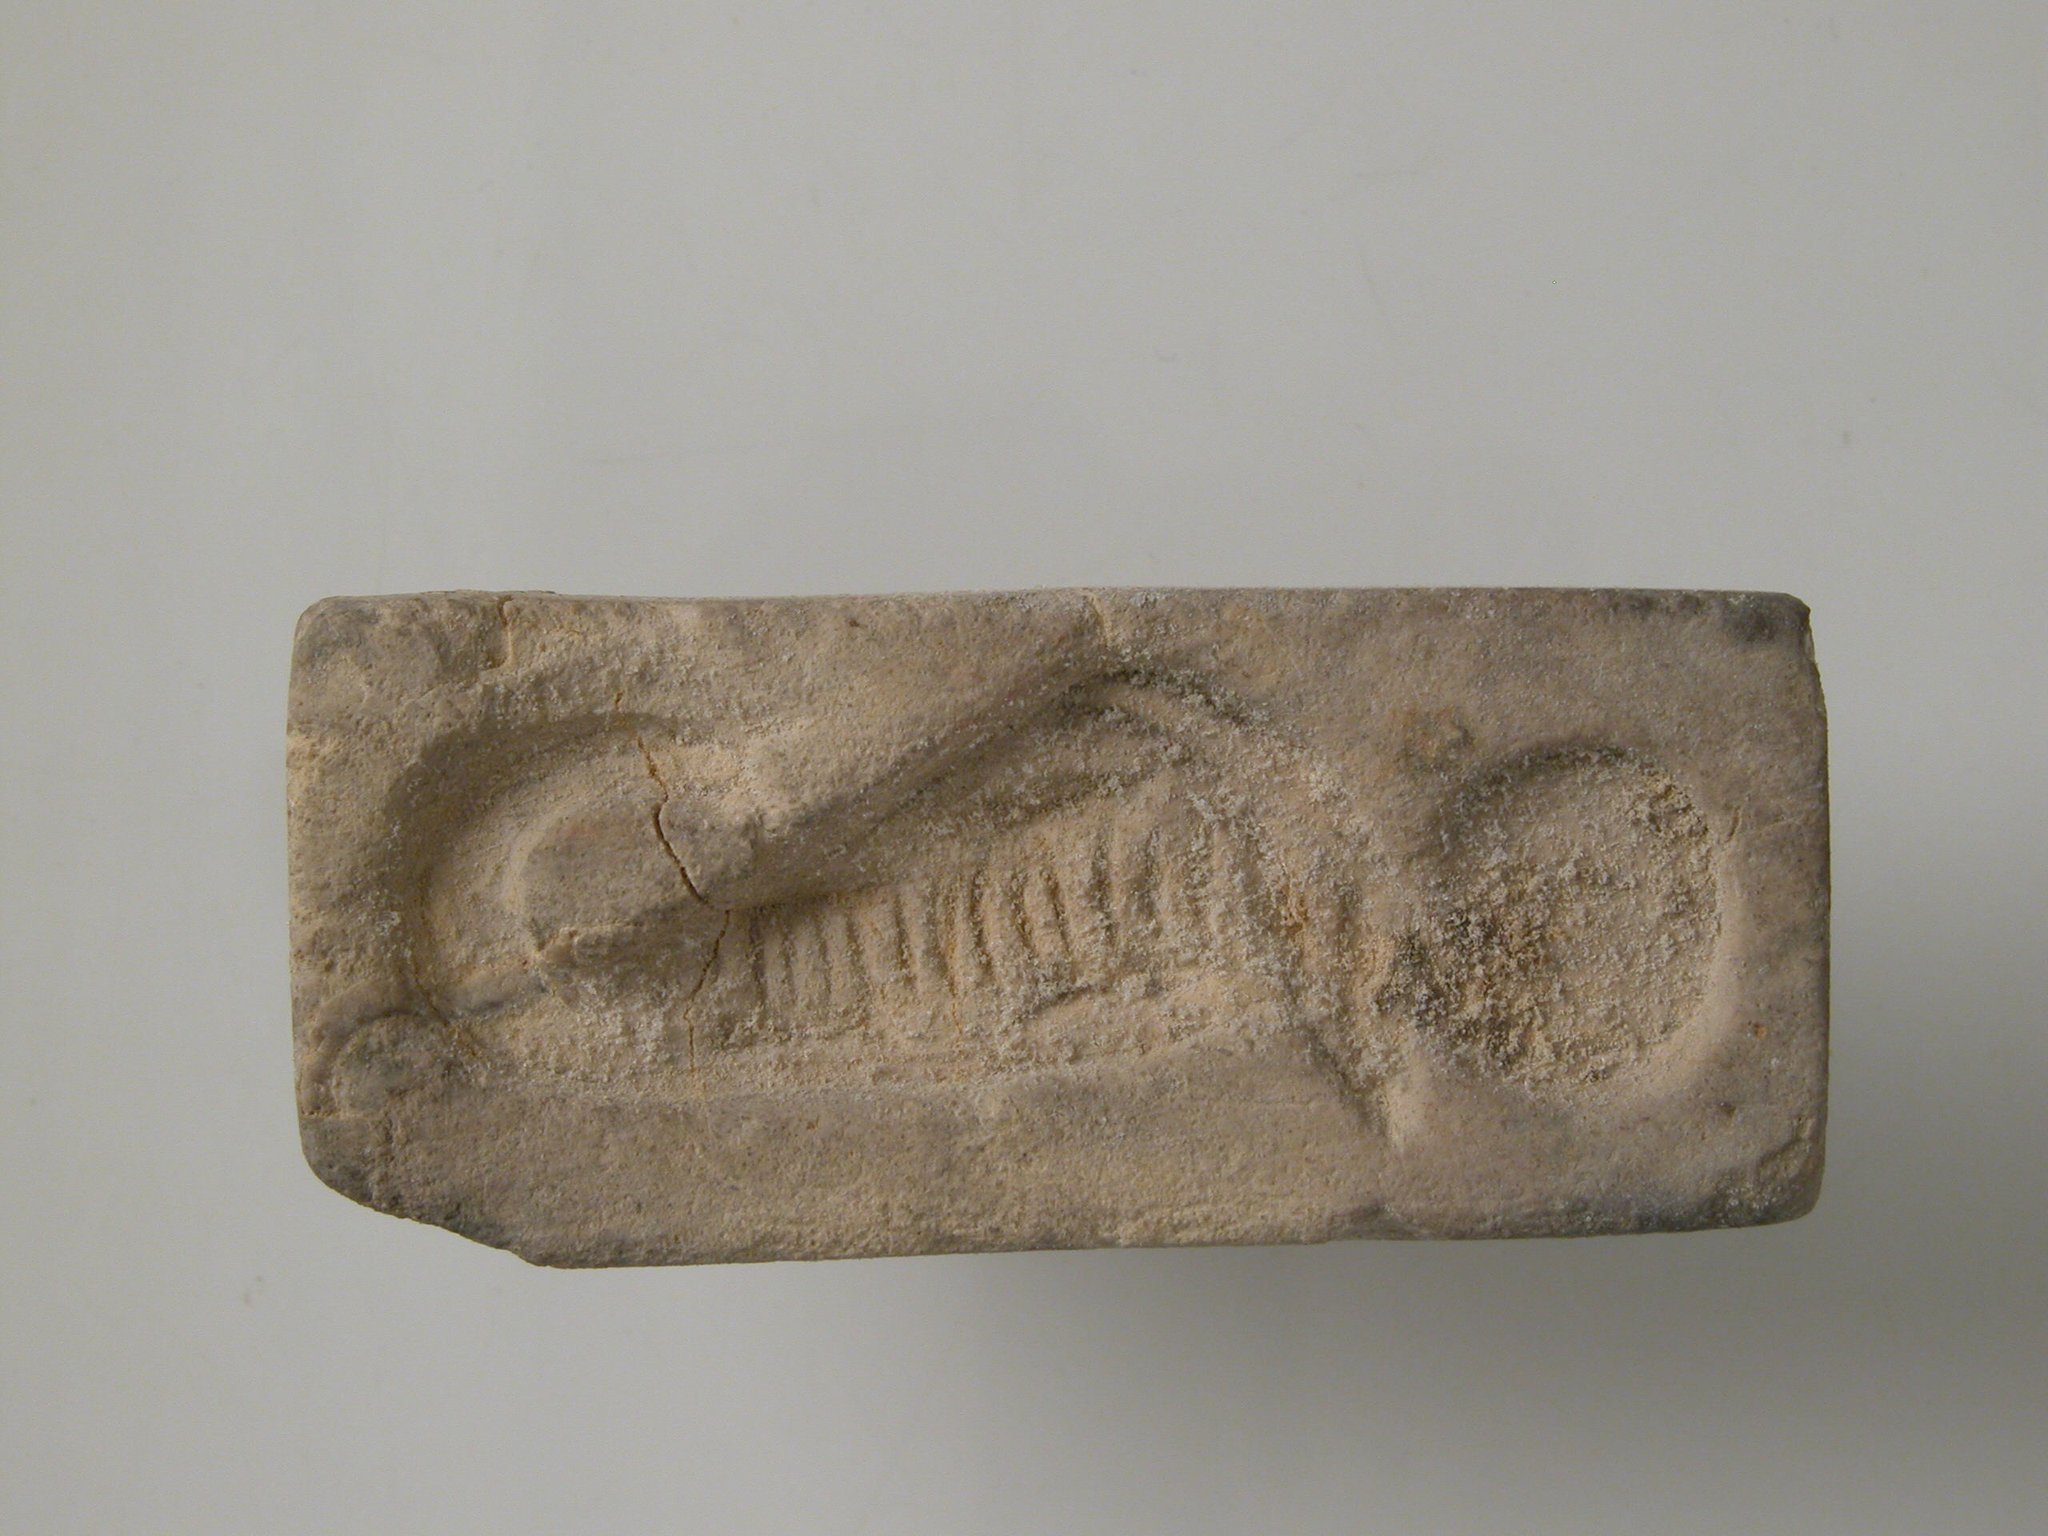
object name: stamp, uraeus, sun disk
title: Stamp with uraeus and sun disk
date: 712-343 BCE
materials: limestone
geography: egypt